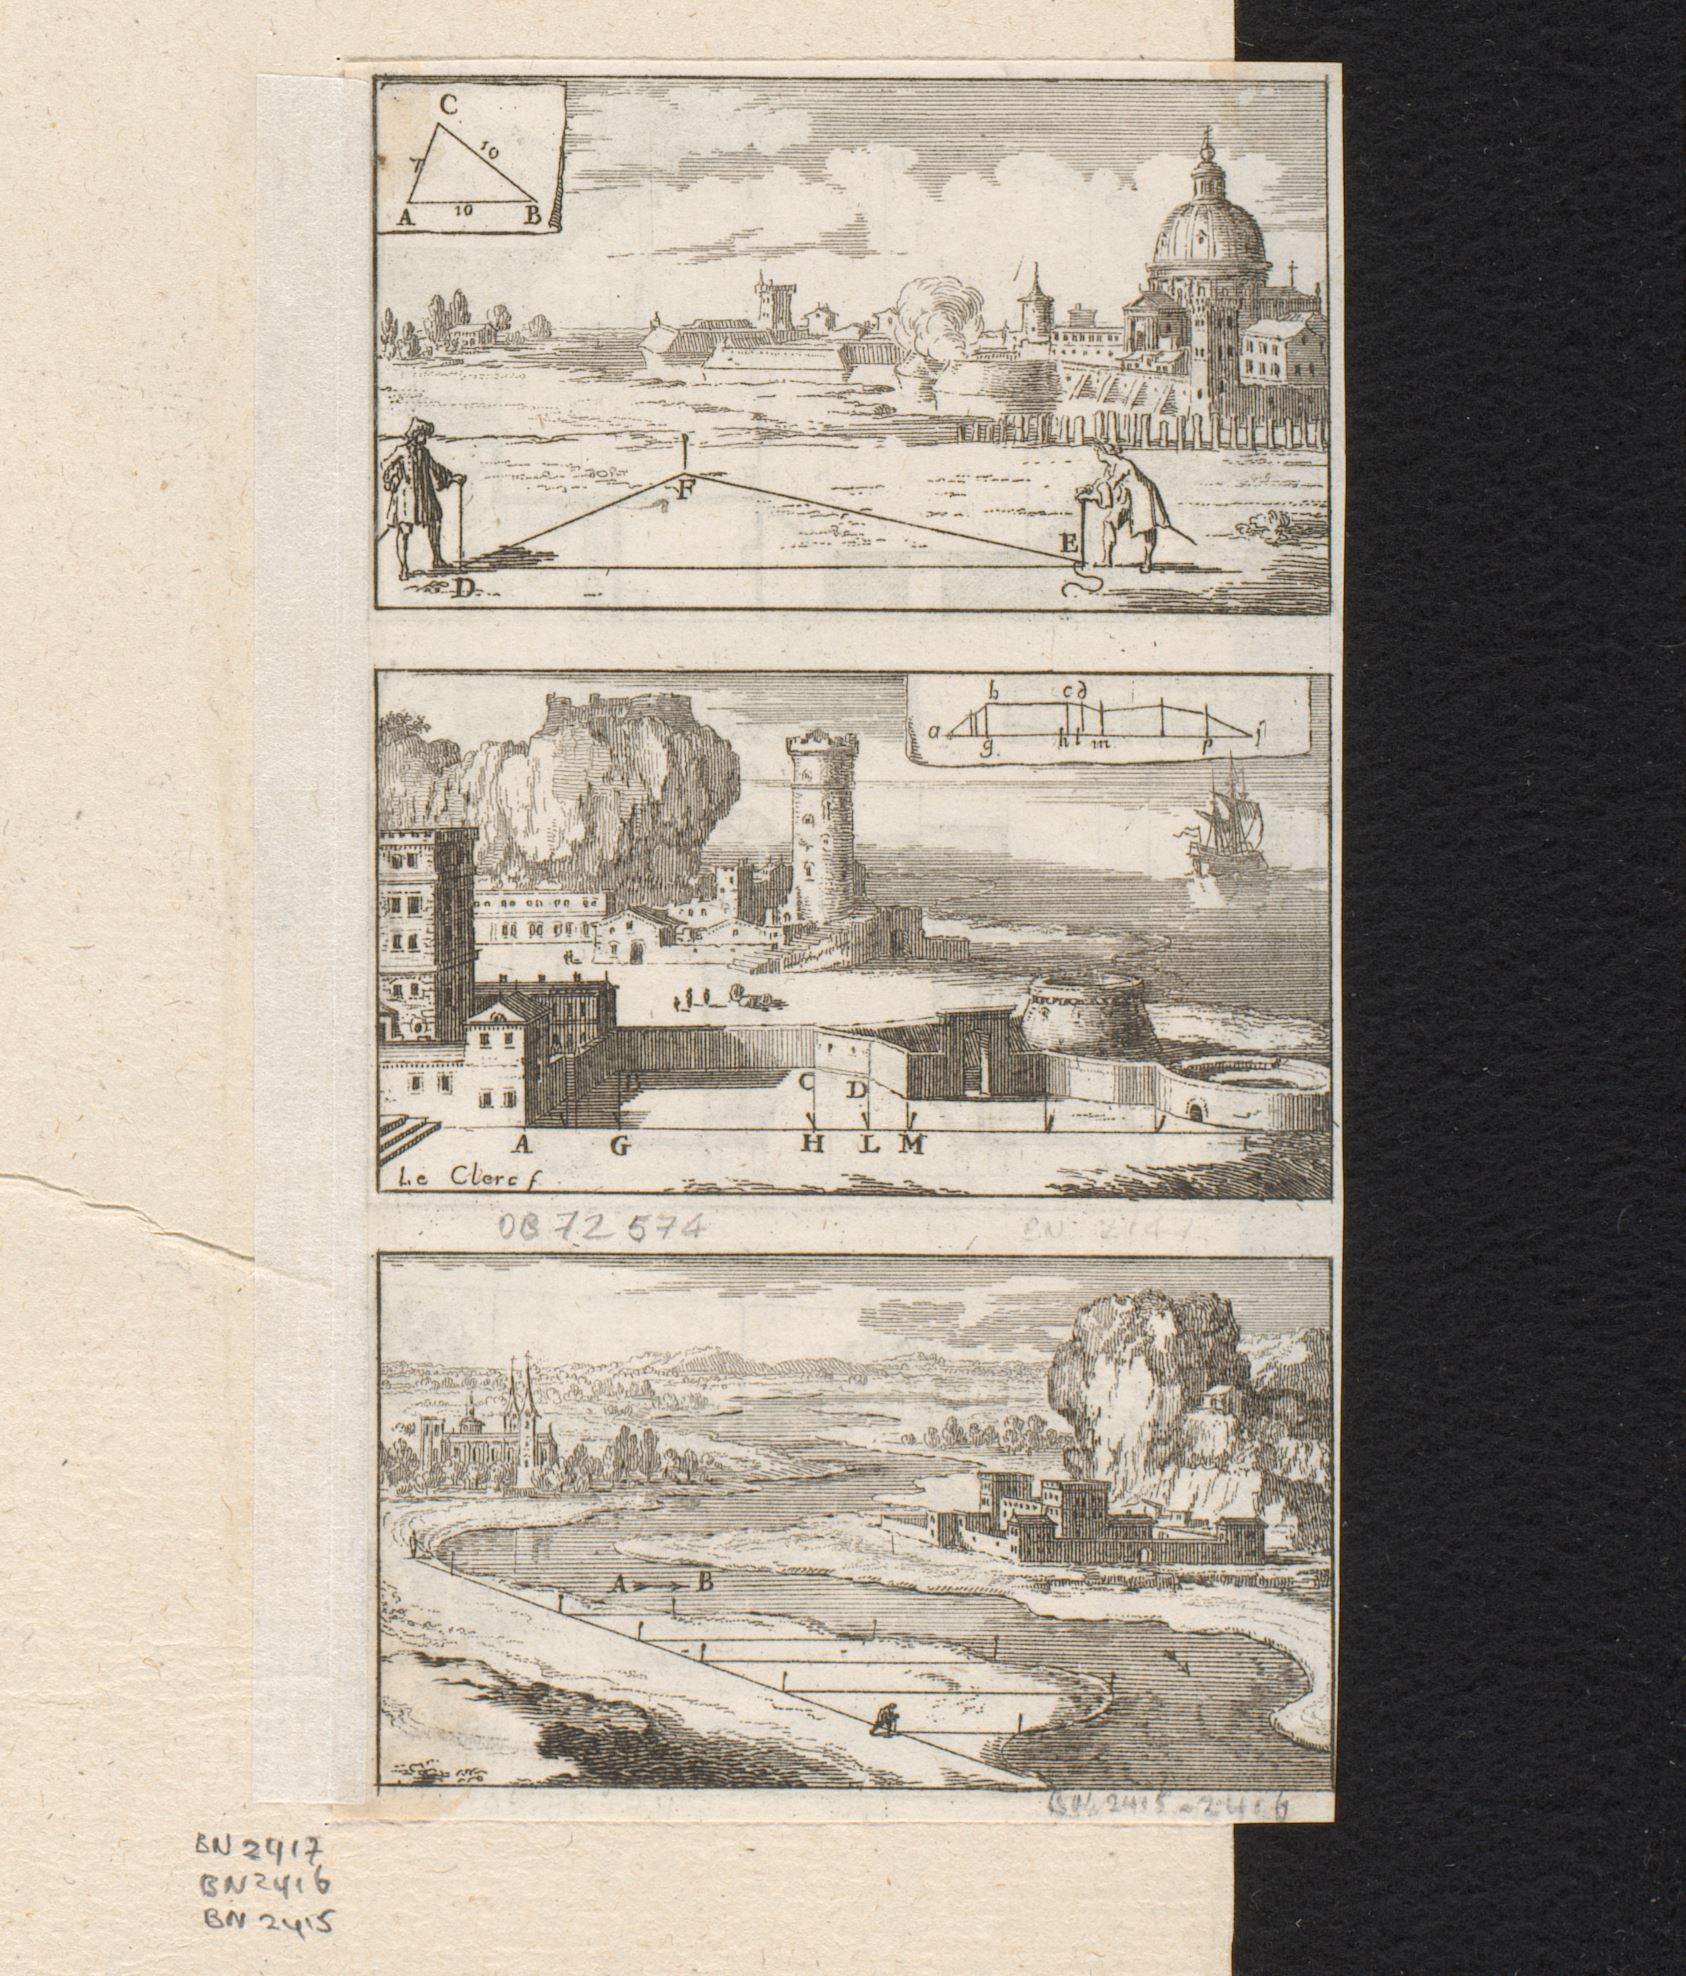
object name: print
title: Gebruik van een meetlint geïllustreerd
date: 1690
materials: paper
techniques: etching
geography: france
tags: landscapes with waters, waterscapes, seascapes (in the temperate zone), church (exterior), planimetry, geometry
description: Prent uit: Leclerc, Sébastien. Traité de géométrie (...). Parijs: Jean Jombert, 1690.